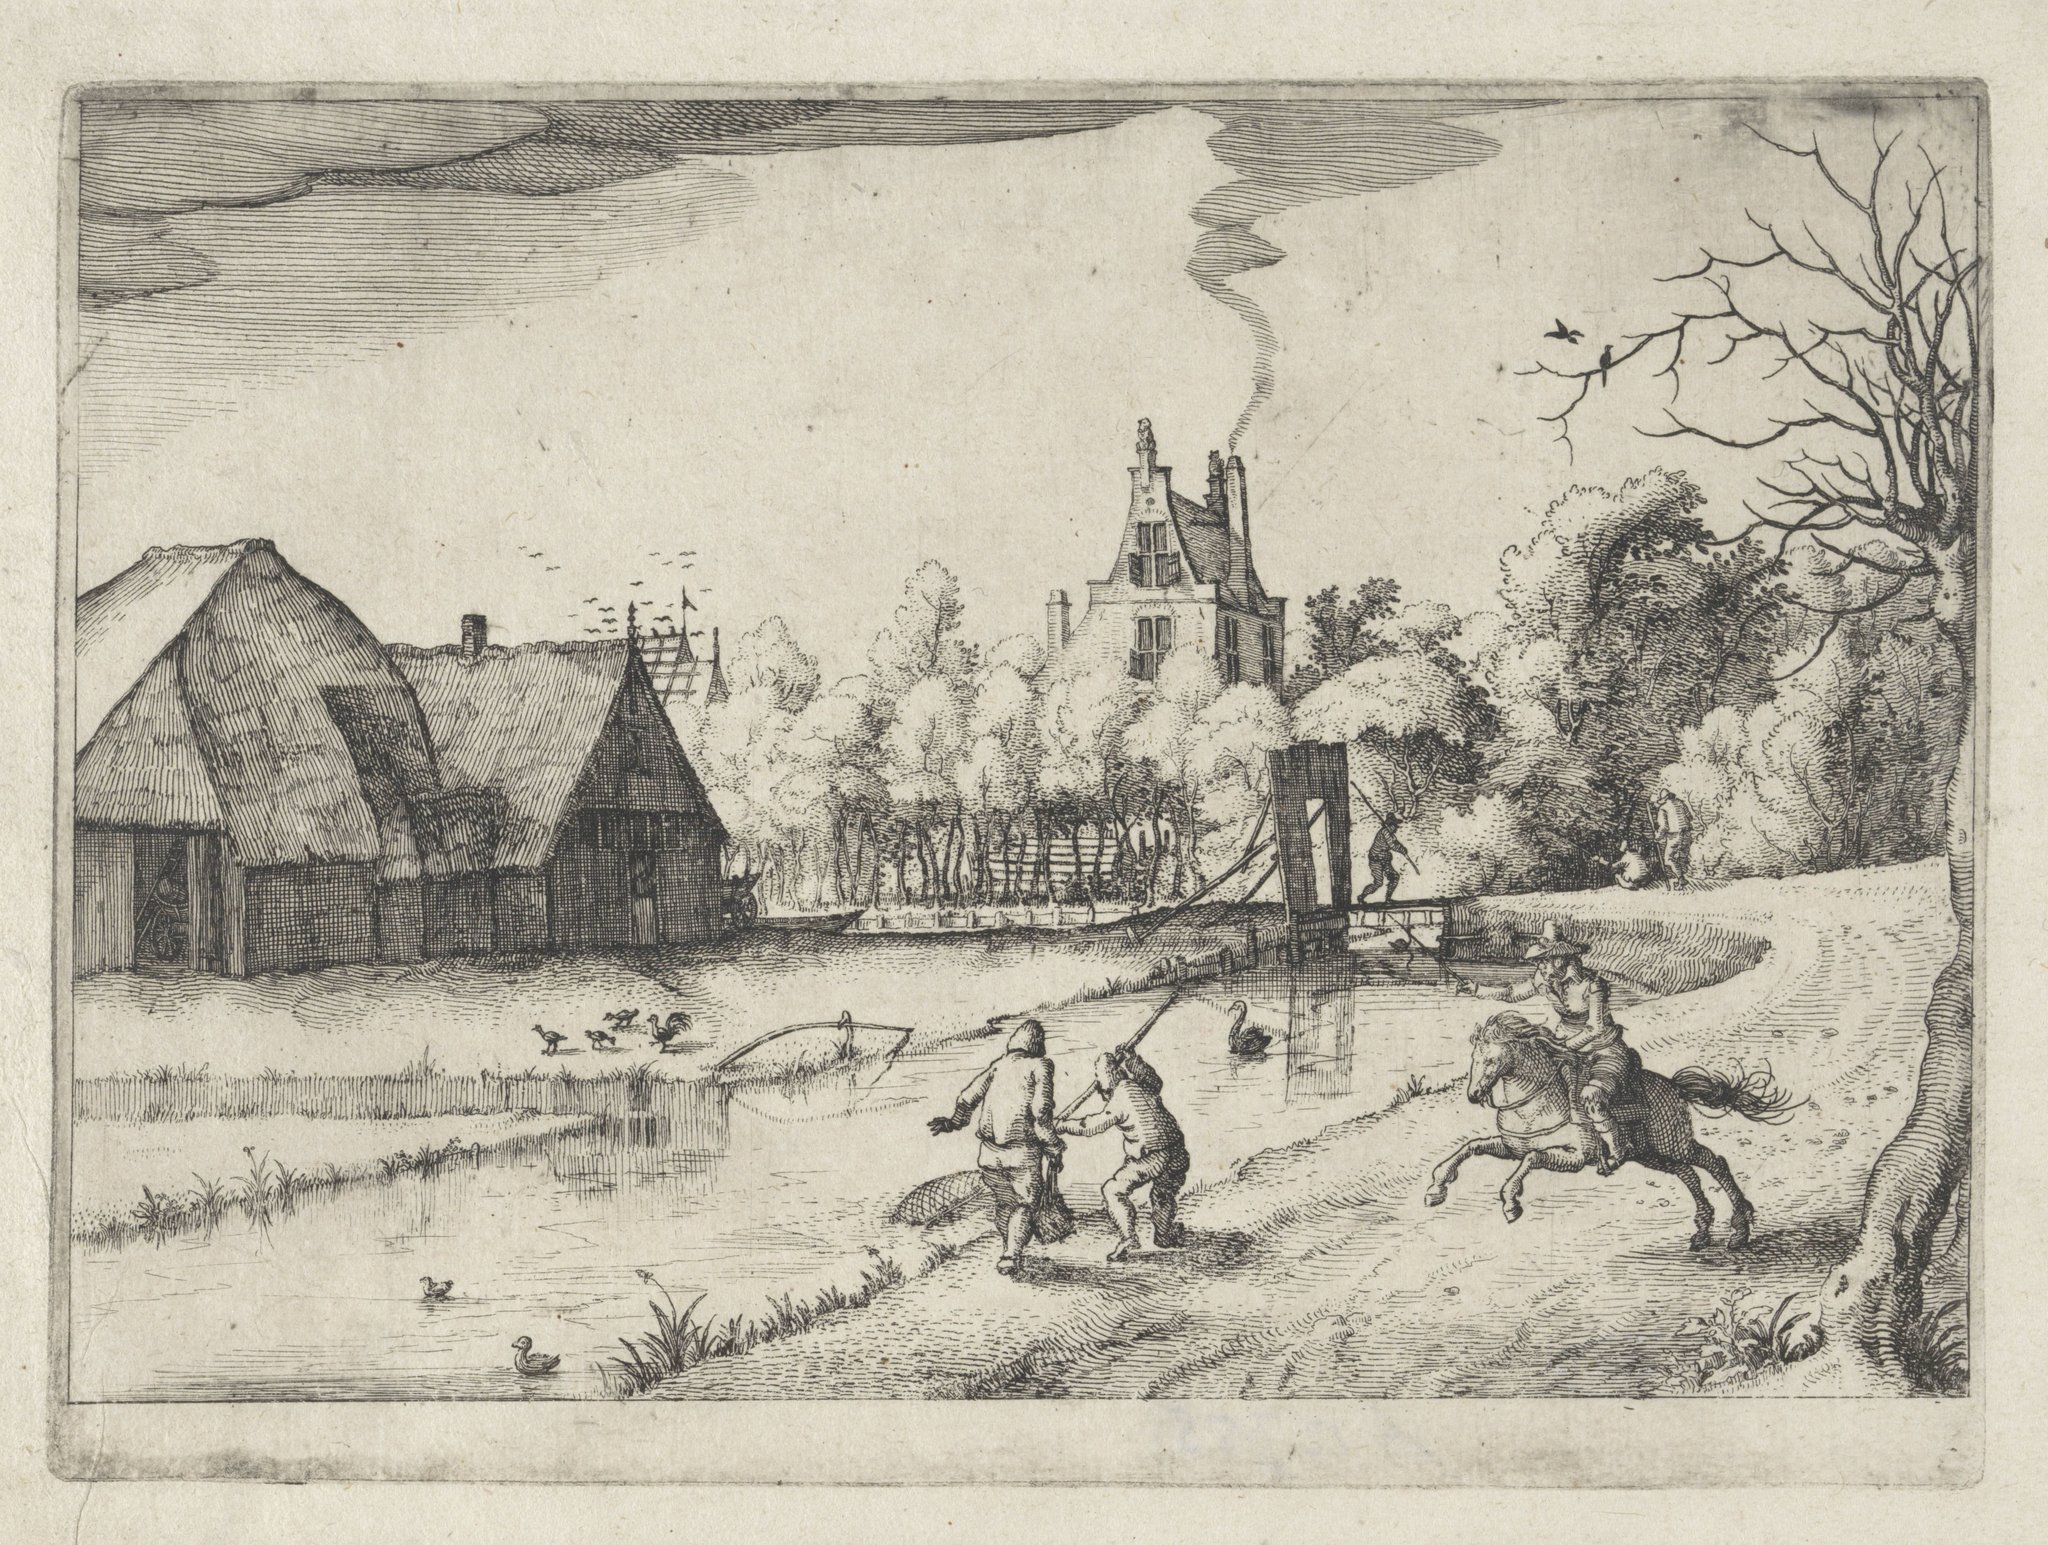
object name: print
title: Landhuis en boomgaard van Jan Daimen, bij Sloterdijk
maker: claes jansz. visscher (ii)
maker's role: draughtsman, print maker, publisher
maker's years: 1586-1652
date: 1596-1630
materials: paper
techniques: etching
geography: amsterdam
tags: castle, fishing (sports), orchard, sloterdijk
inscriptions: collector's mark: Lugt 2228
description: Gezicht op het landhuis met bijgebouwen en de boomgaard van Jan Daimen. Op de voorgrond twee hengelaars, met netten vissend in de gracht. Een ruiter komt aanrijden. Op het tweede plan een houten bruggetje, waarachter de boomgaard. Het dak van het landhuis te zien tussen de bomen. .